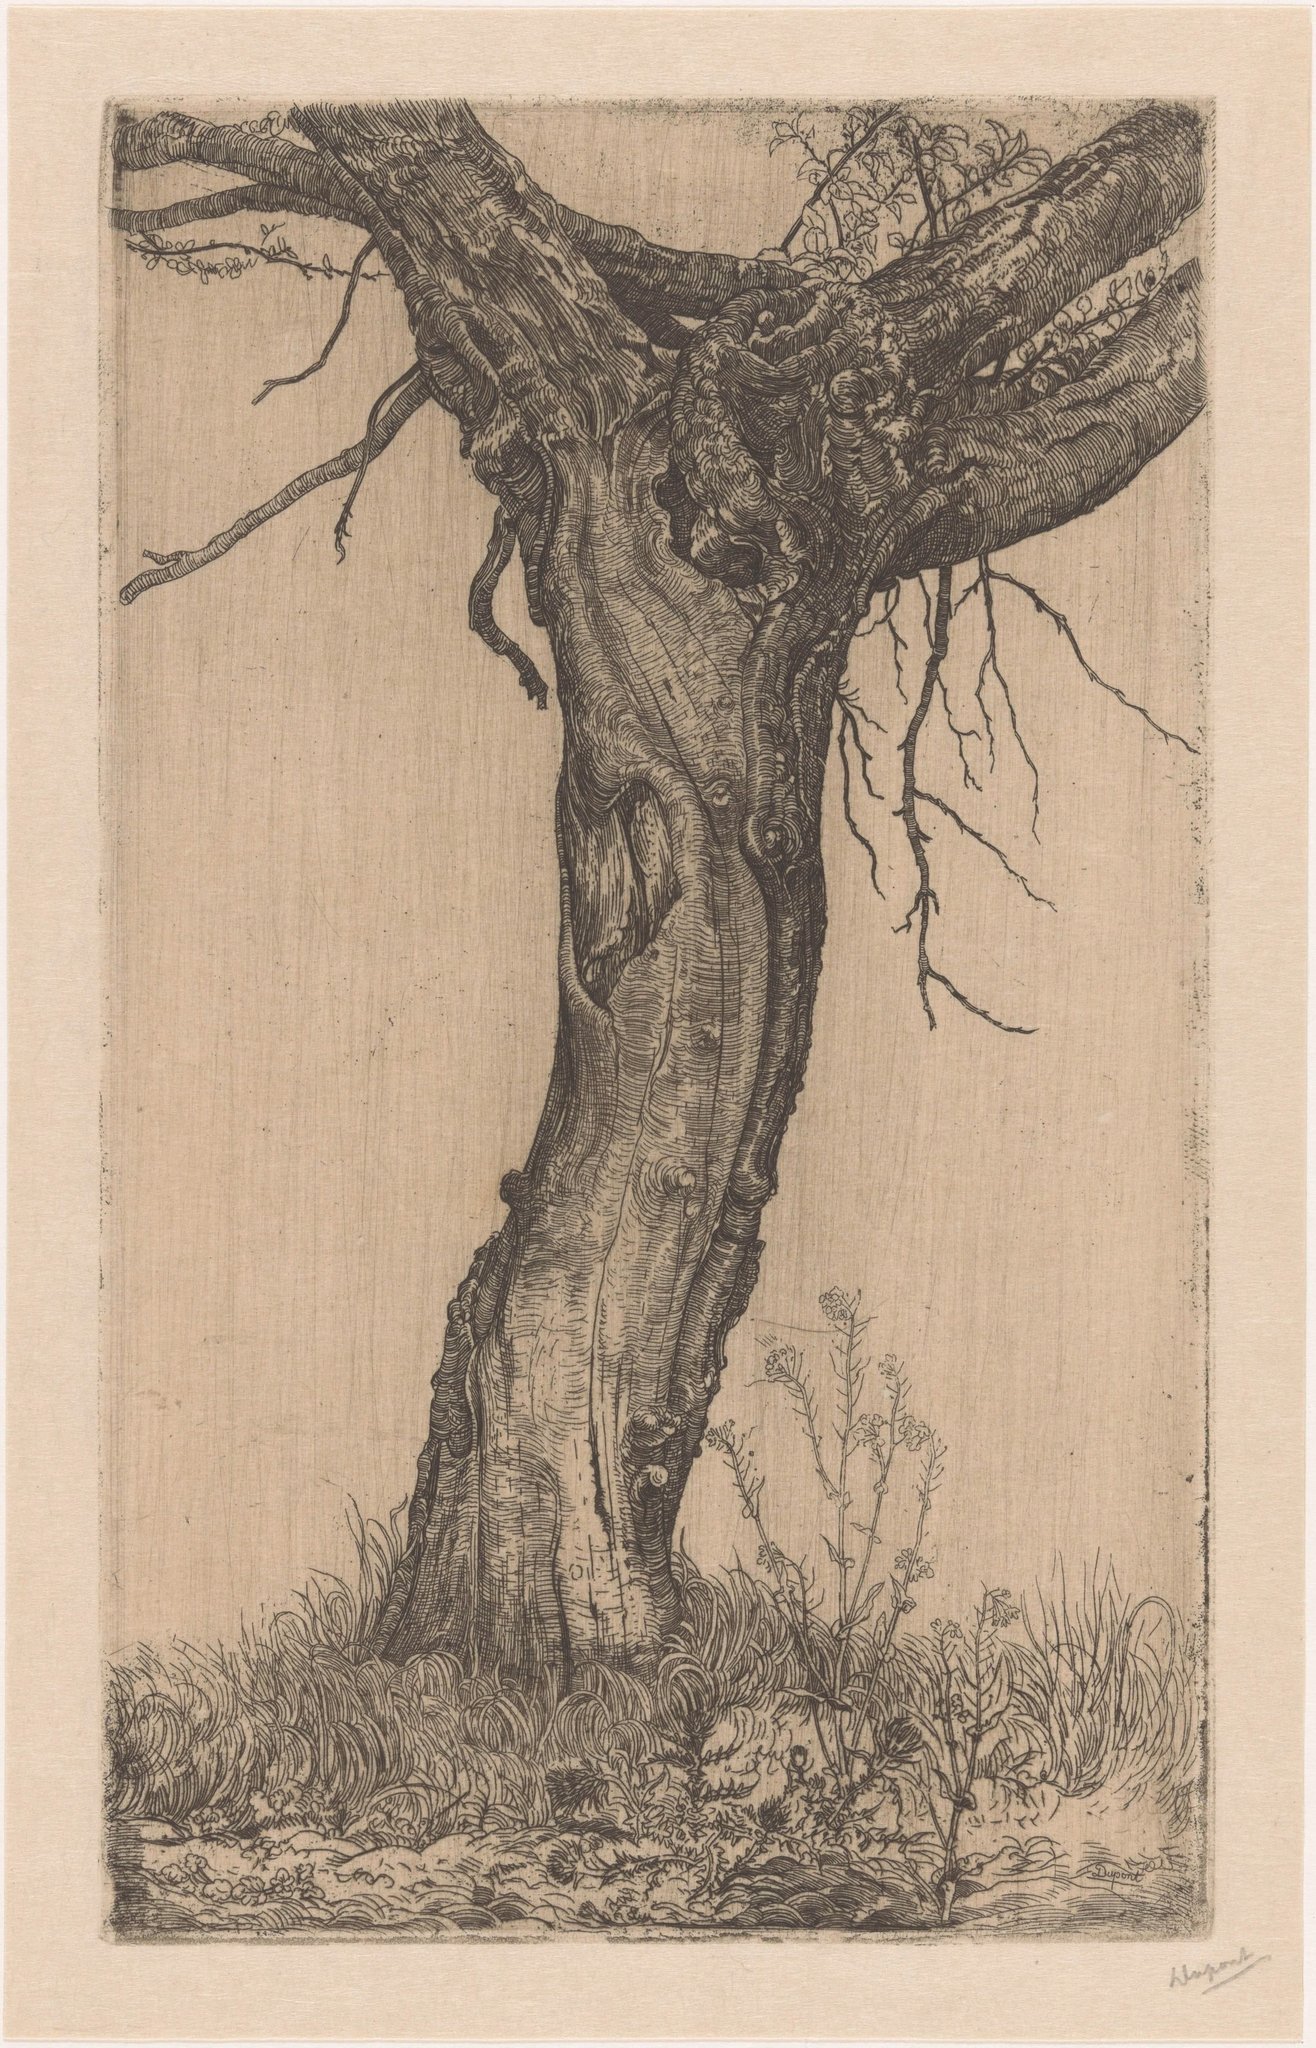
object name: print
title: Wilg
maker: pieter dupont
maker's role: draughtsman, print maker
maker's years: 1870-1911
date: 1896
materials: paper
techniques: intaglio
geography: netherlands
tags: trees: willow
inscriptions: collector's mark: Lugt 2228